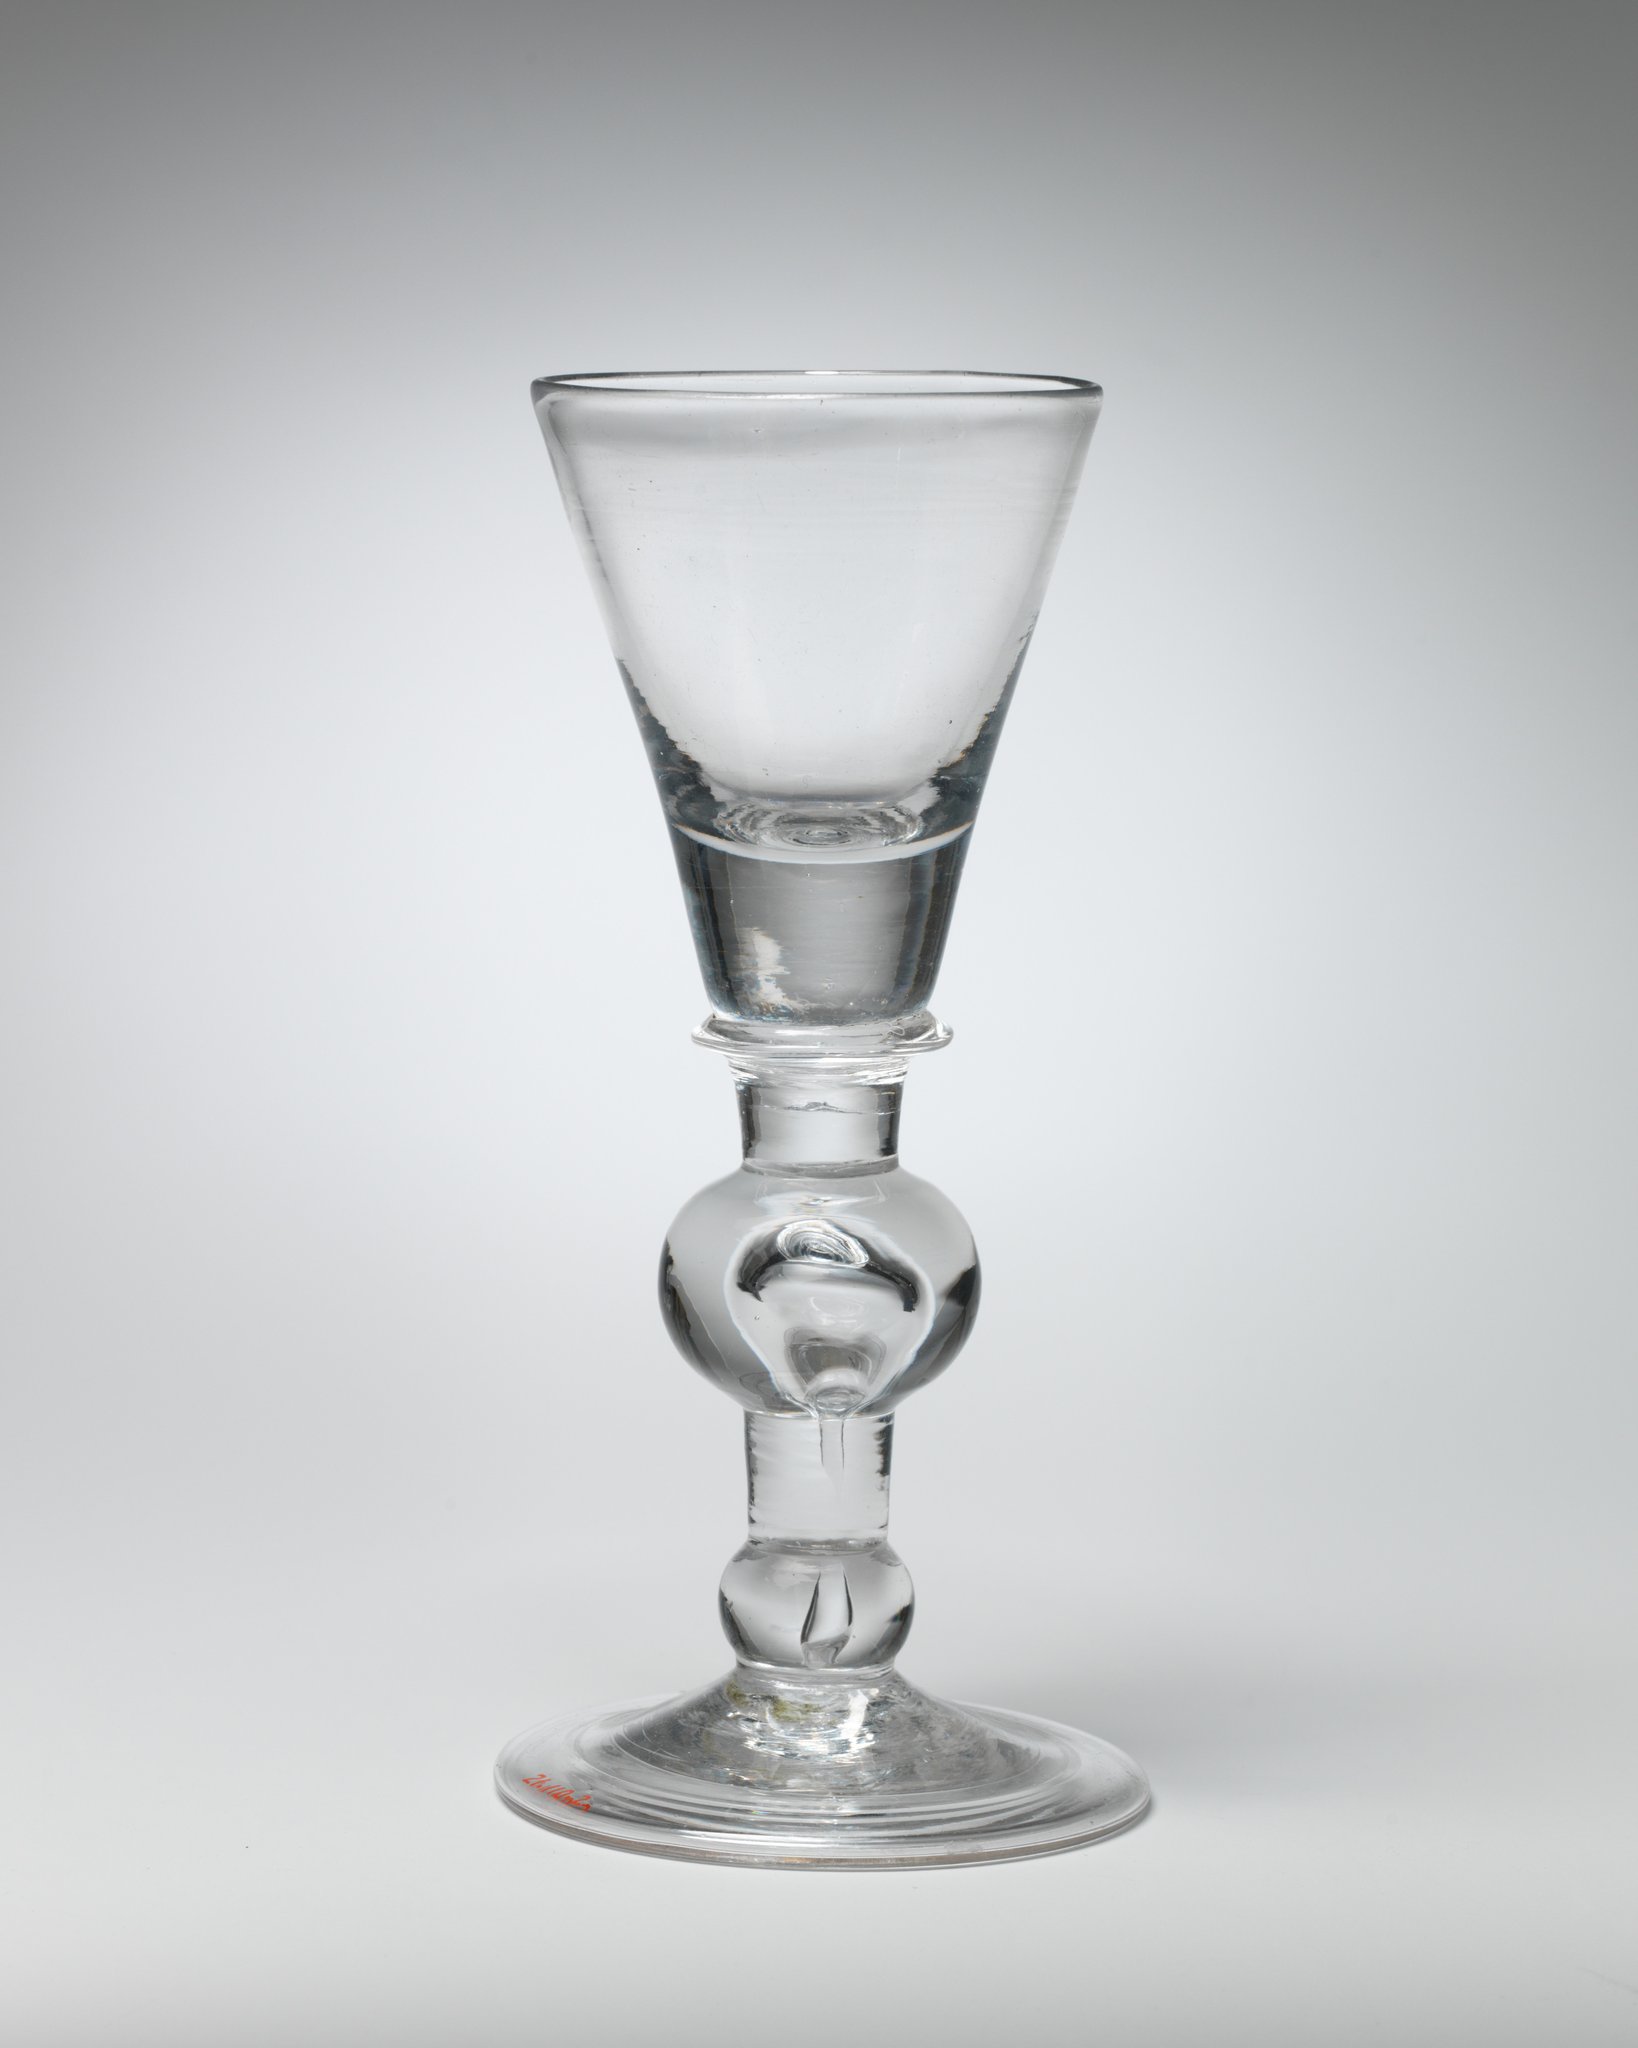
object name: wineglass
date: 1667-1733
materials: glass